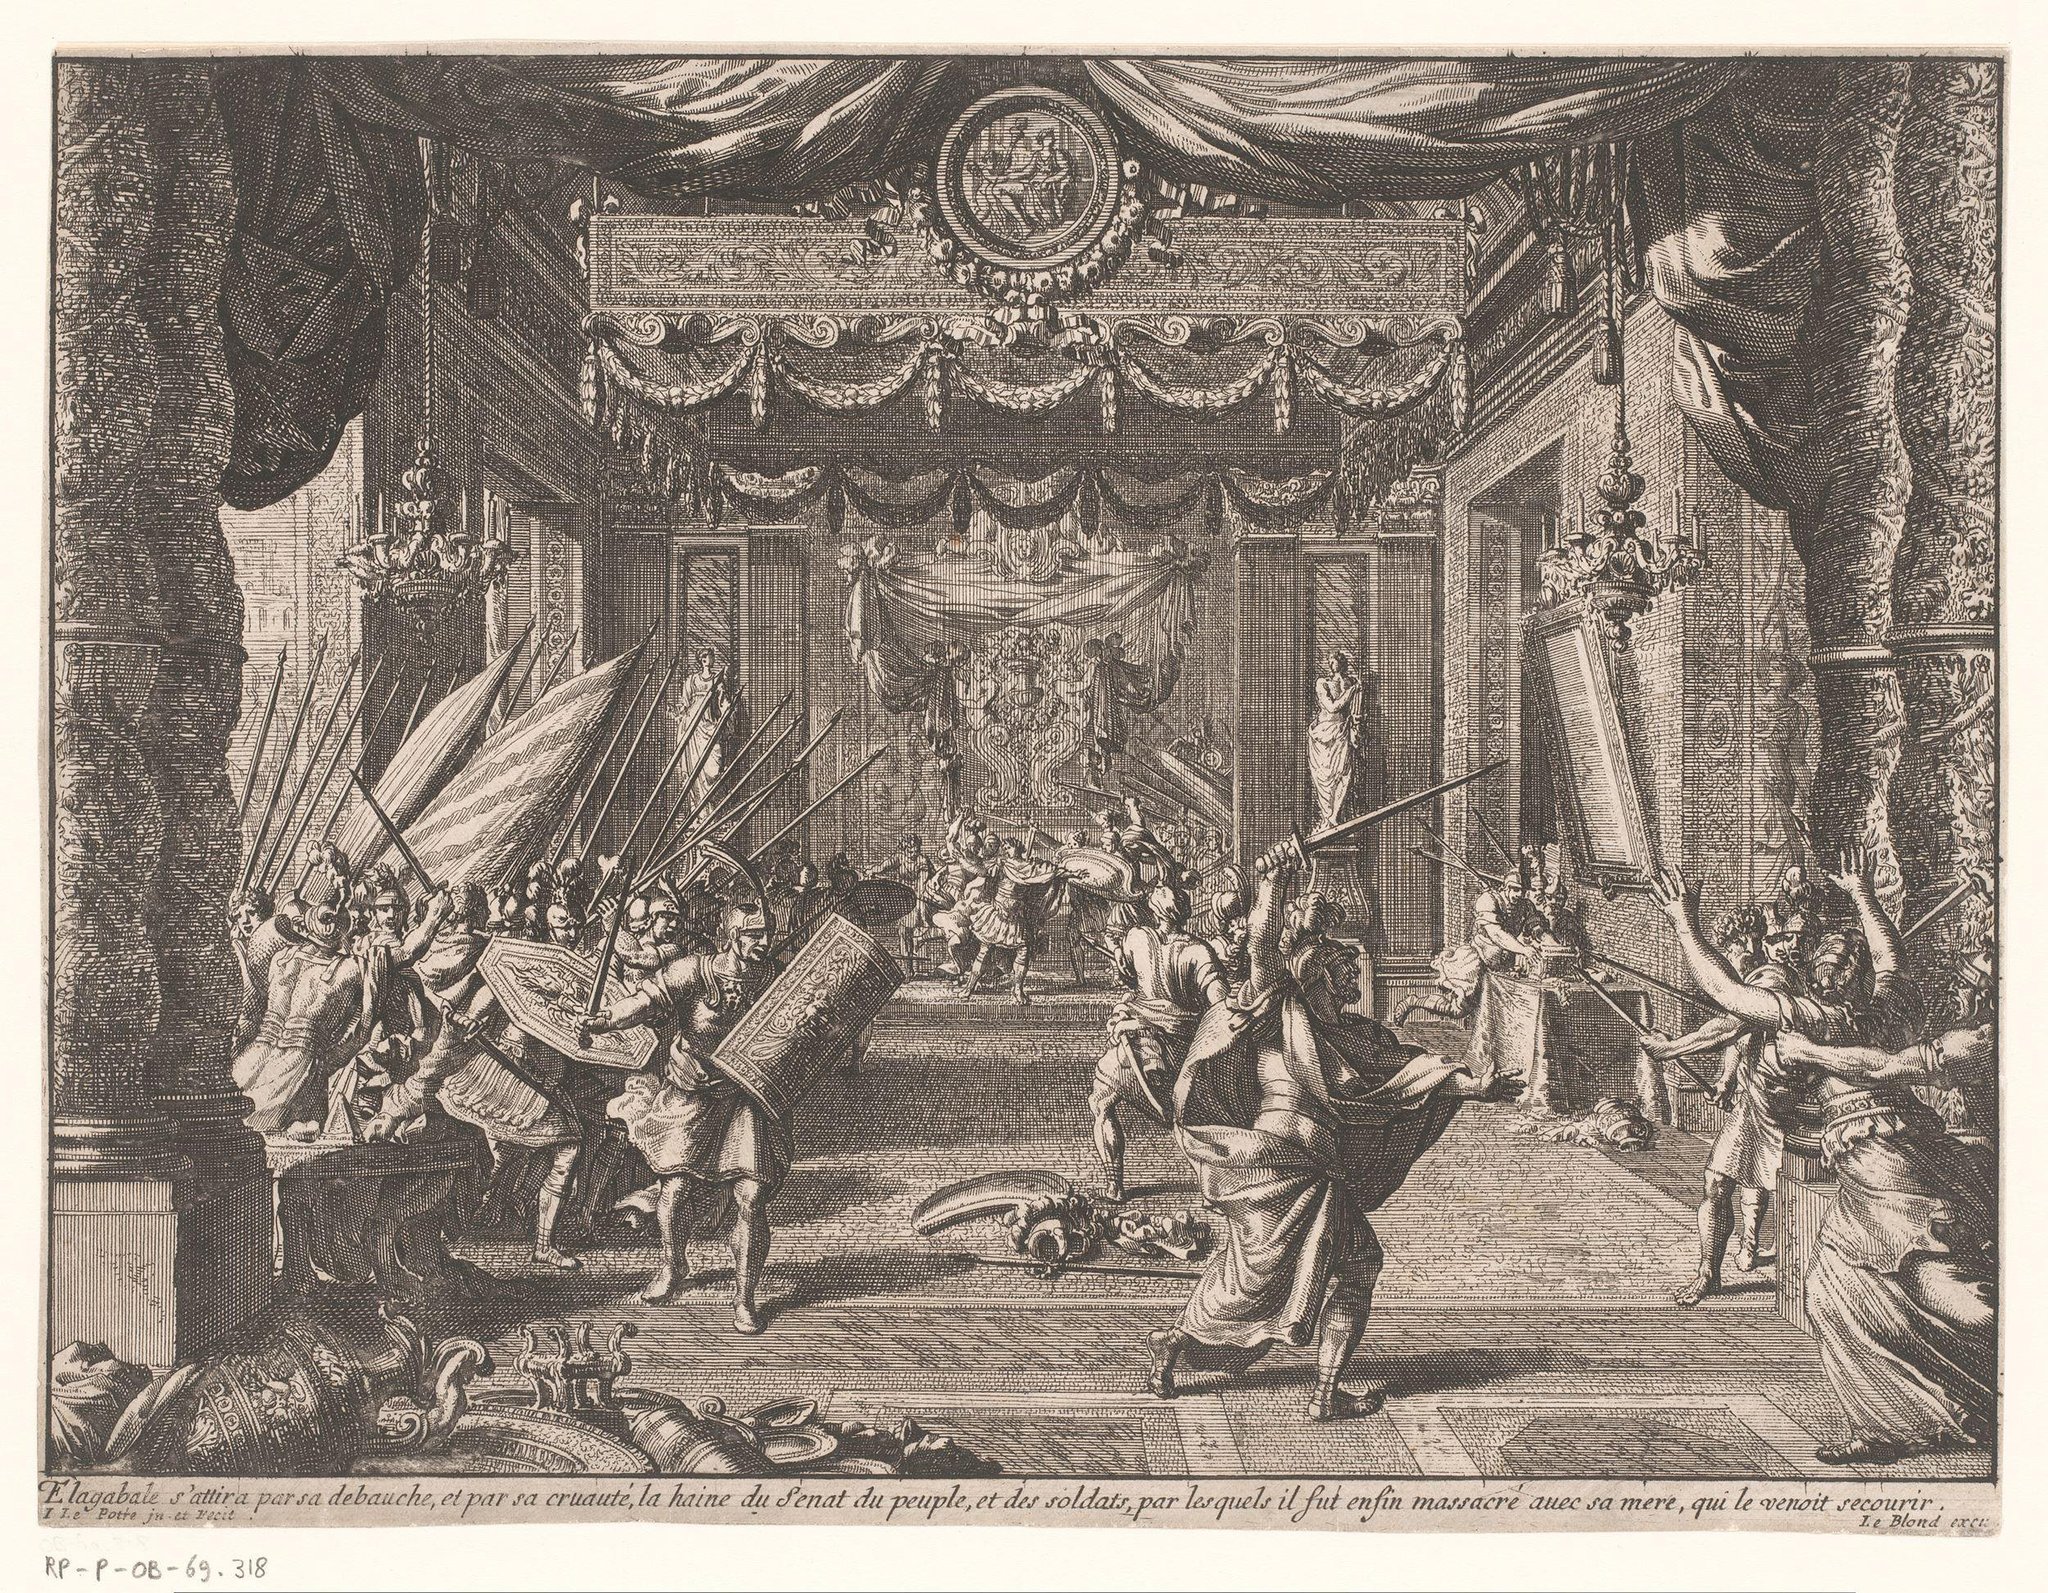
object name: print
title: Heliogabalus door de senaat en de soldaten met zijn moeder vermoord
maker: jean lepautre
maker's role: draughtsman, print maker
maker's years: 1618-1682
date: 1628-1682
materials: paper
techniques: etching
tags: other foreign deities included in the classical pantheon (with name)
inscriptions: collector's mark: Lugt 2228